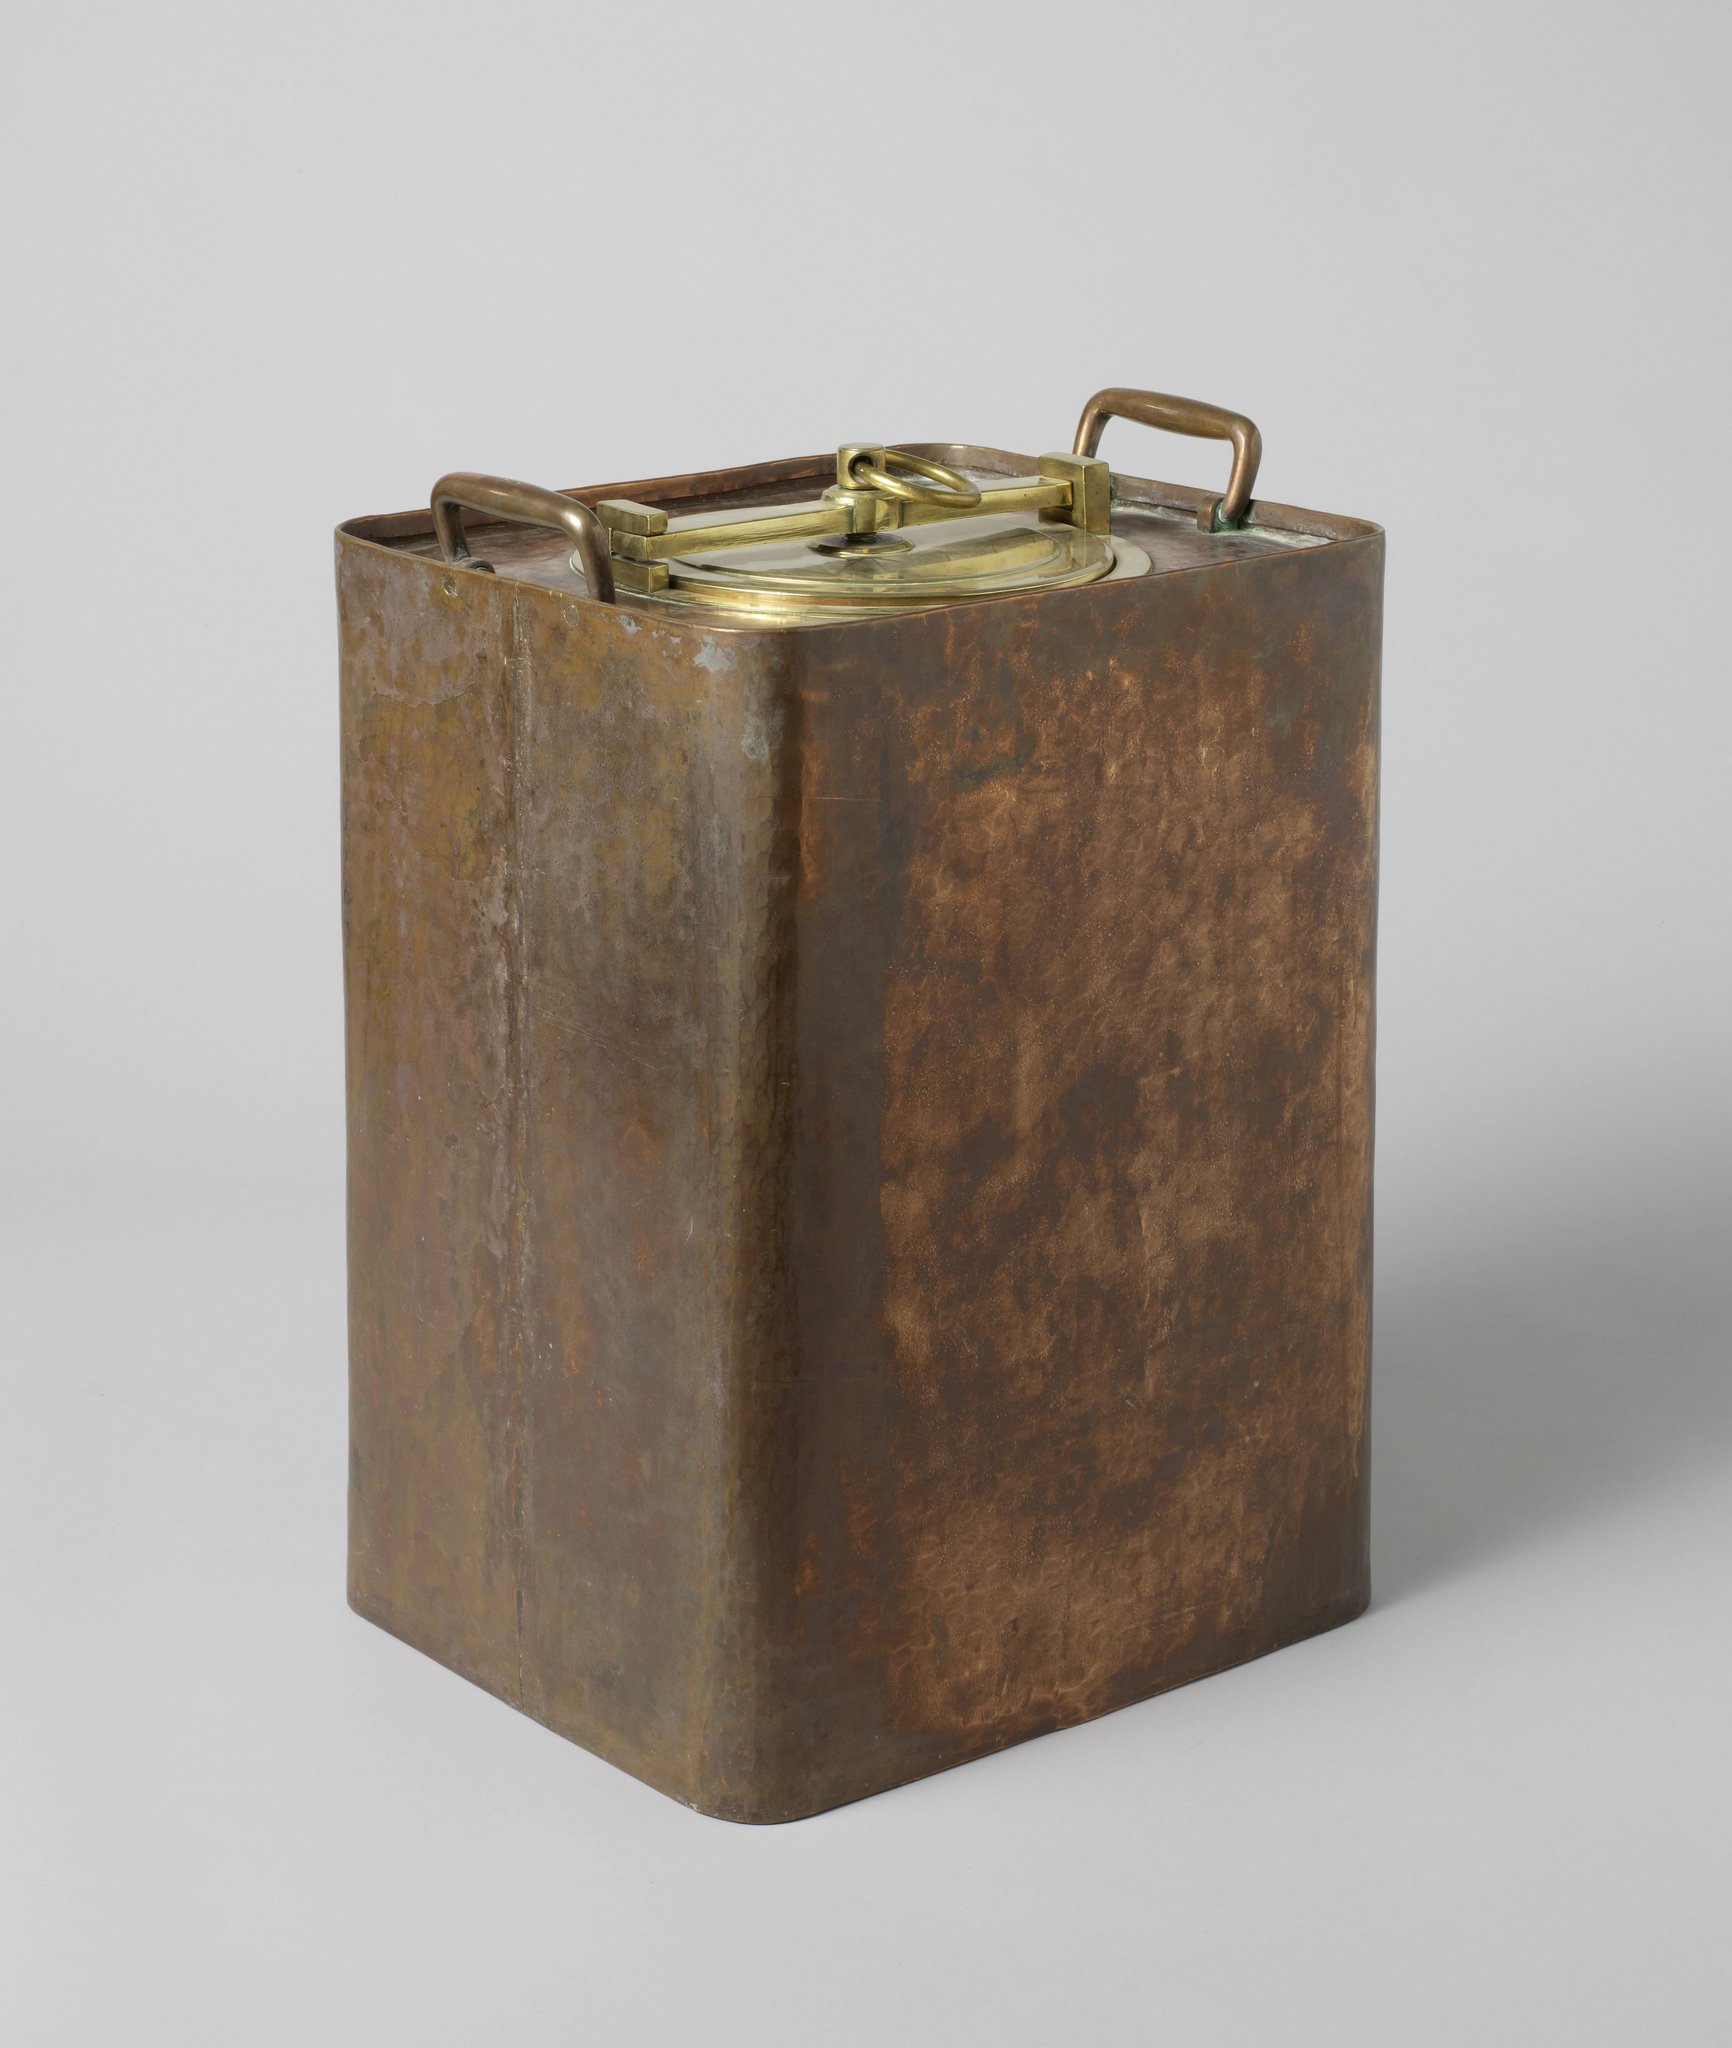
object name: chest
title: Powder Chest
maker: Anonymous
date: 1859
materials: brass, copper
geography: netherlands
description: Rechthoekige koperen kruitkist met twee handvaten en een rond deksel. Het deksel is voorzien van een wervelsluiting, bestaande uit een messing staaf die draait om een bout in het midden van het deksel en zich onder twee nokken op de buitenrand van de opening vastklemt; met de bout wordt hij vervolgens aangedraaid.